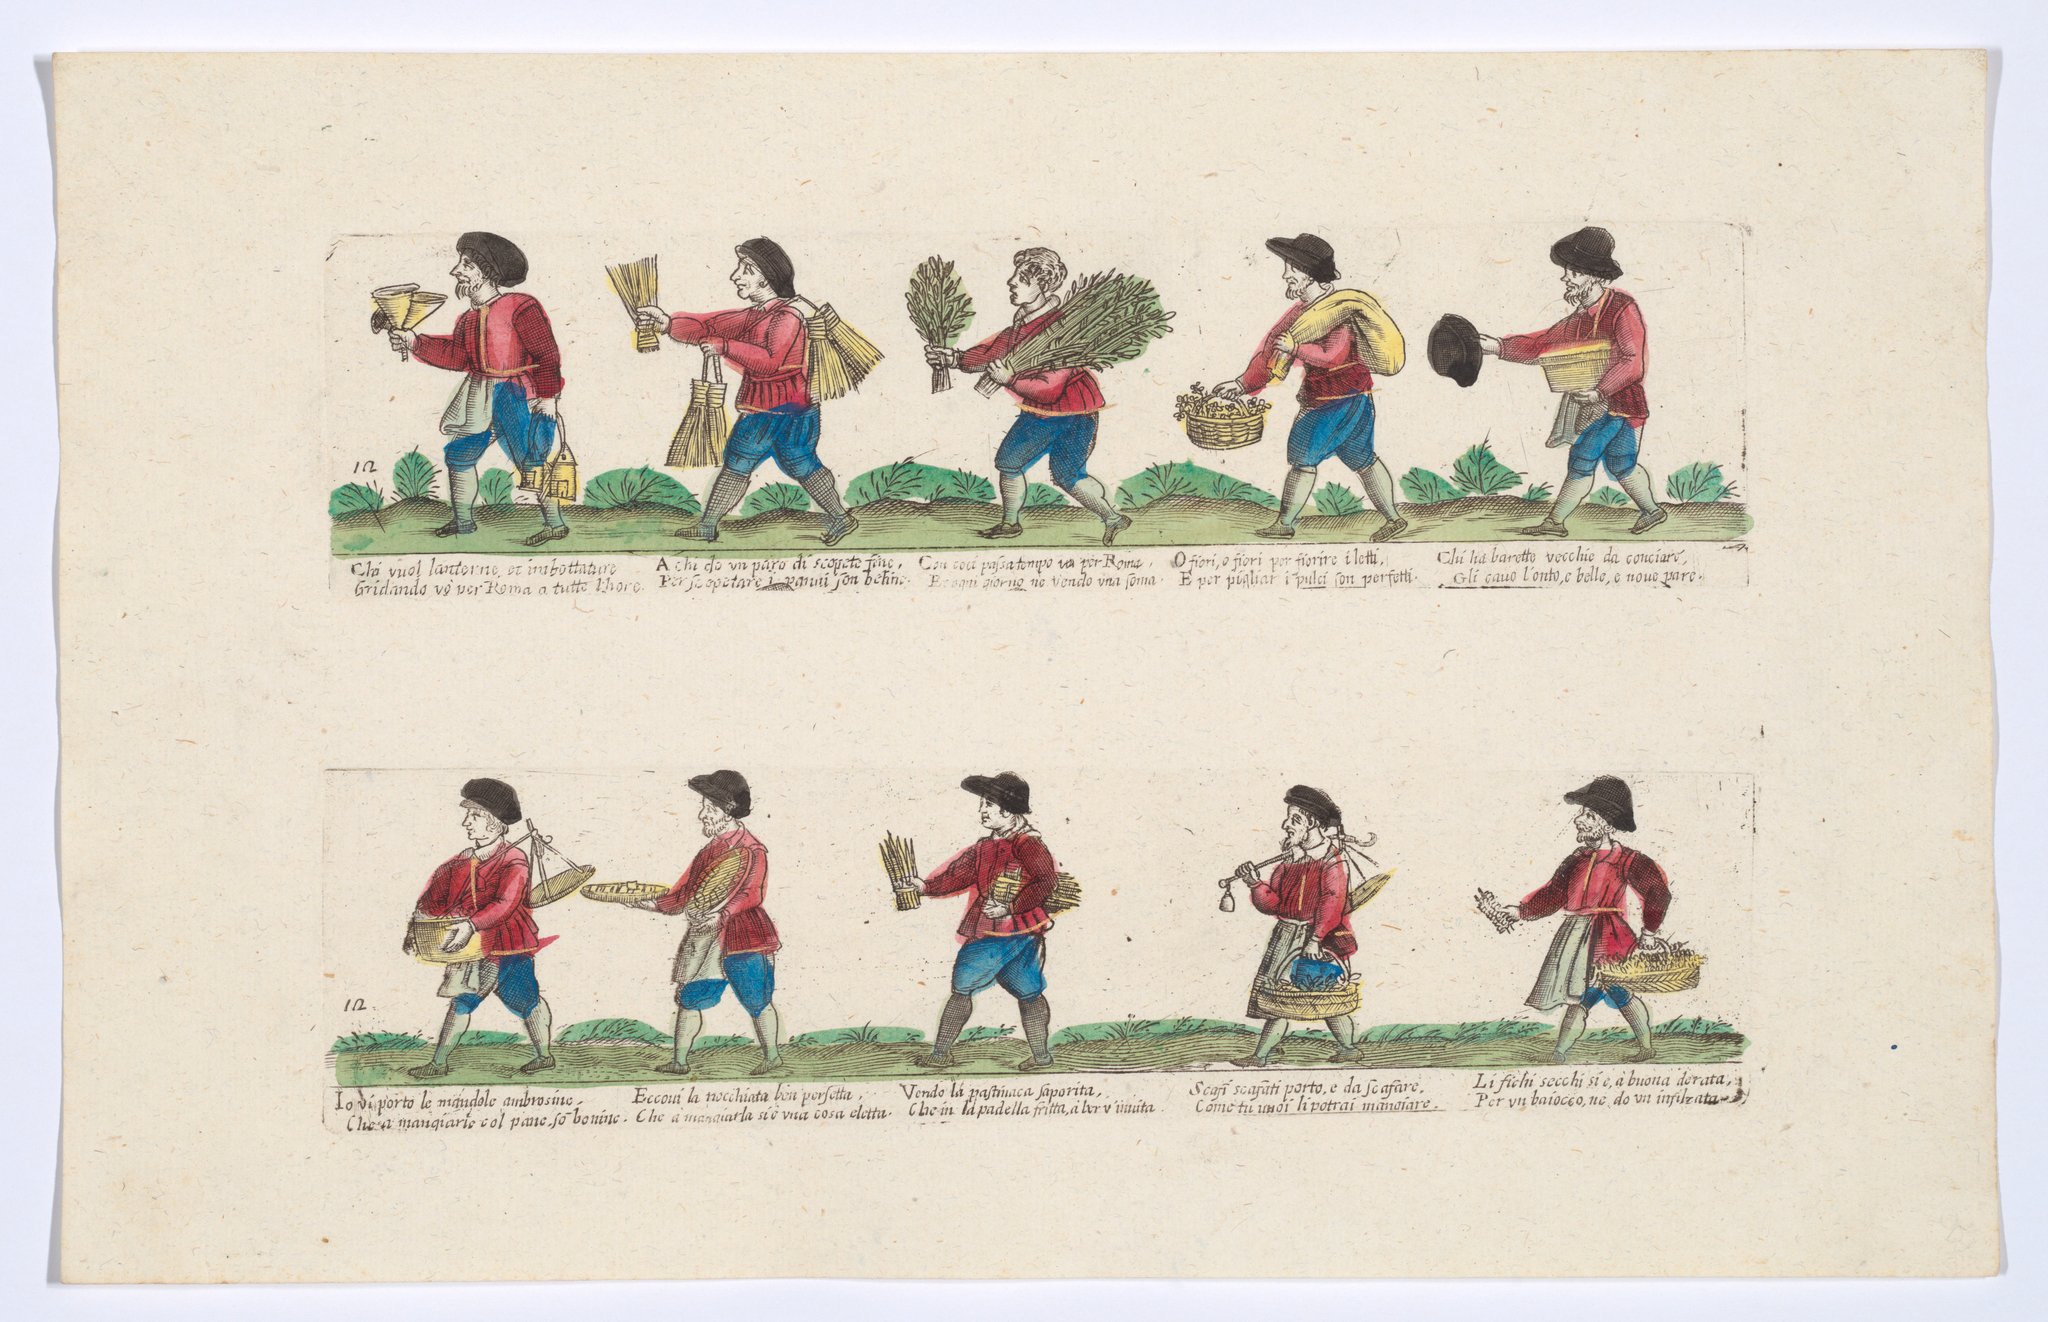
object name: print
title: Plate 12 depicting the trades of Rome, here including vendors of lanterns, brooms, almonds, figs etc, from the 'Descrición de las artes que se llaman para los calles de la ciudad de Roma'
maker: remondini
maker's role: publisher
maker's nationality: italian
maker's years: 1650-1860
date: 1770-1800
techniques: engraving, hand coloring